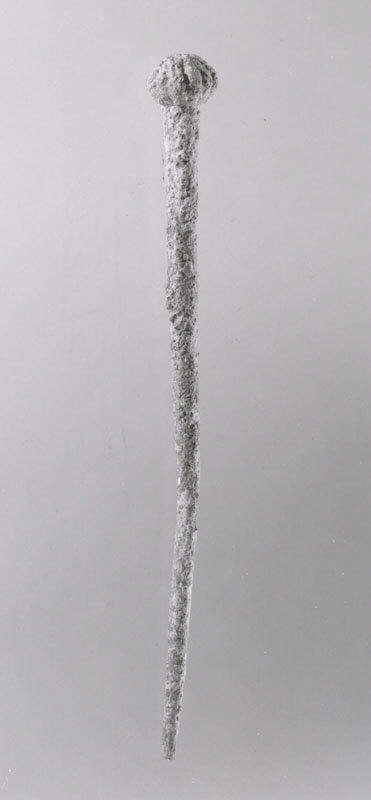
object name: pin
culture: bactria-margiana archaeological complex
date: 2333-1668 BCE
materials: copper alloy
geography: bactria-margiana